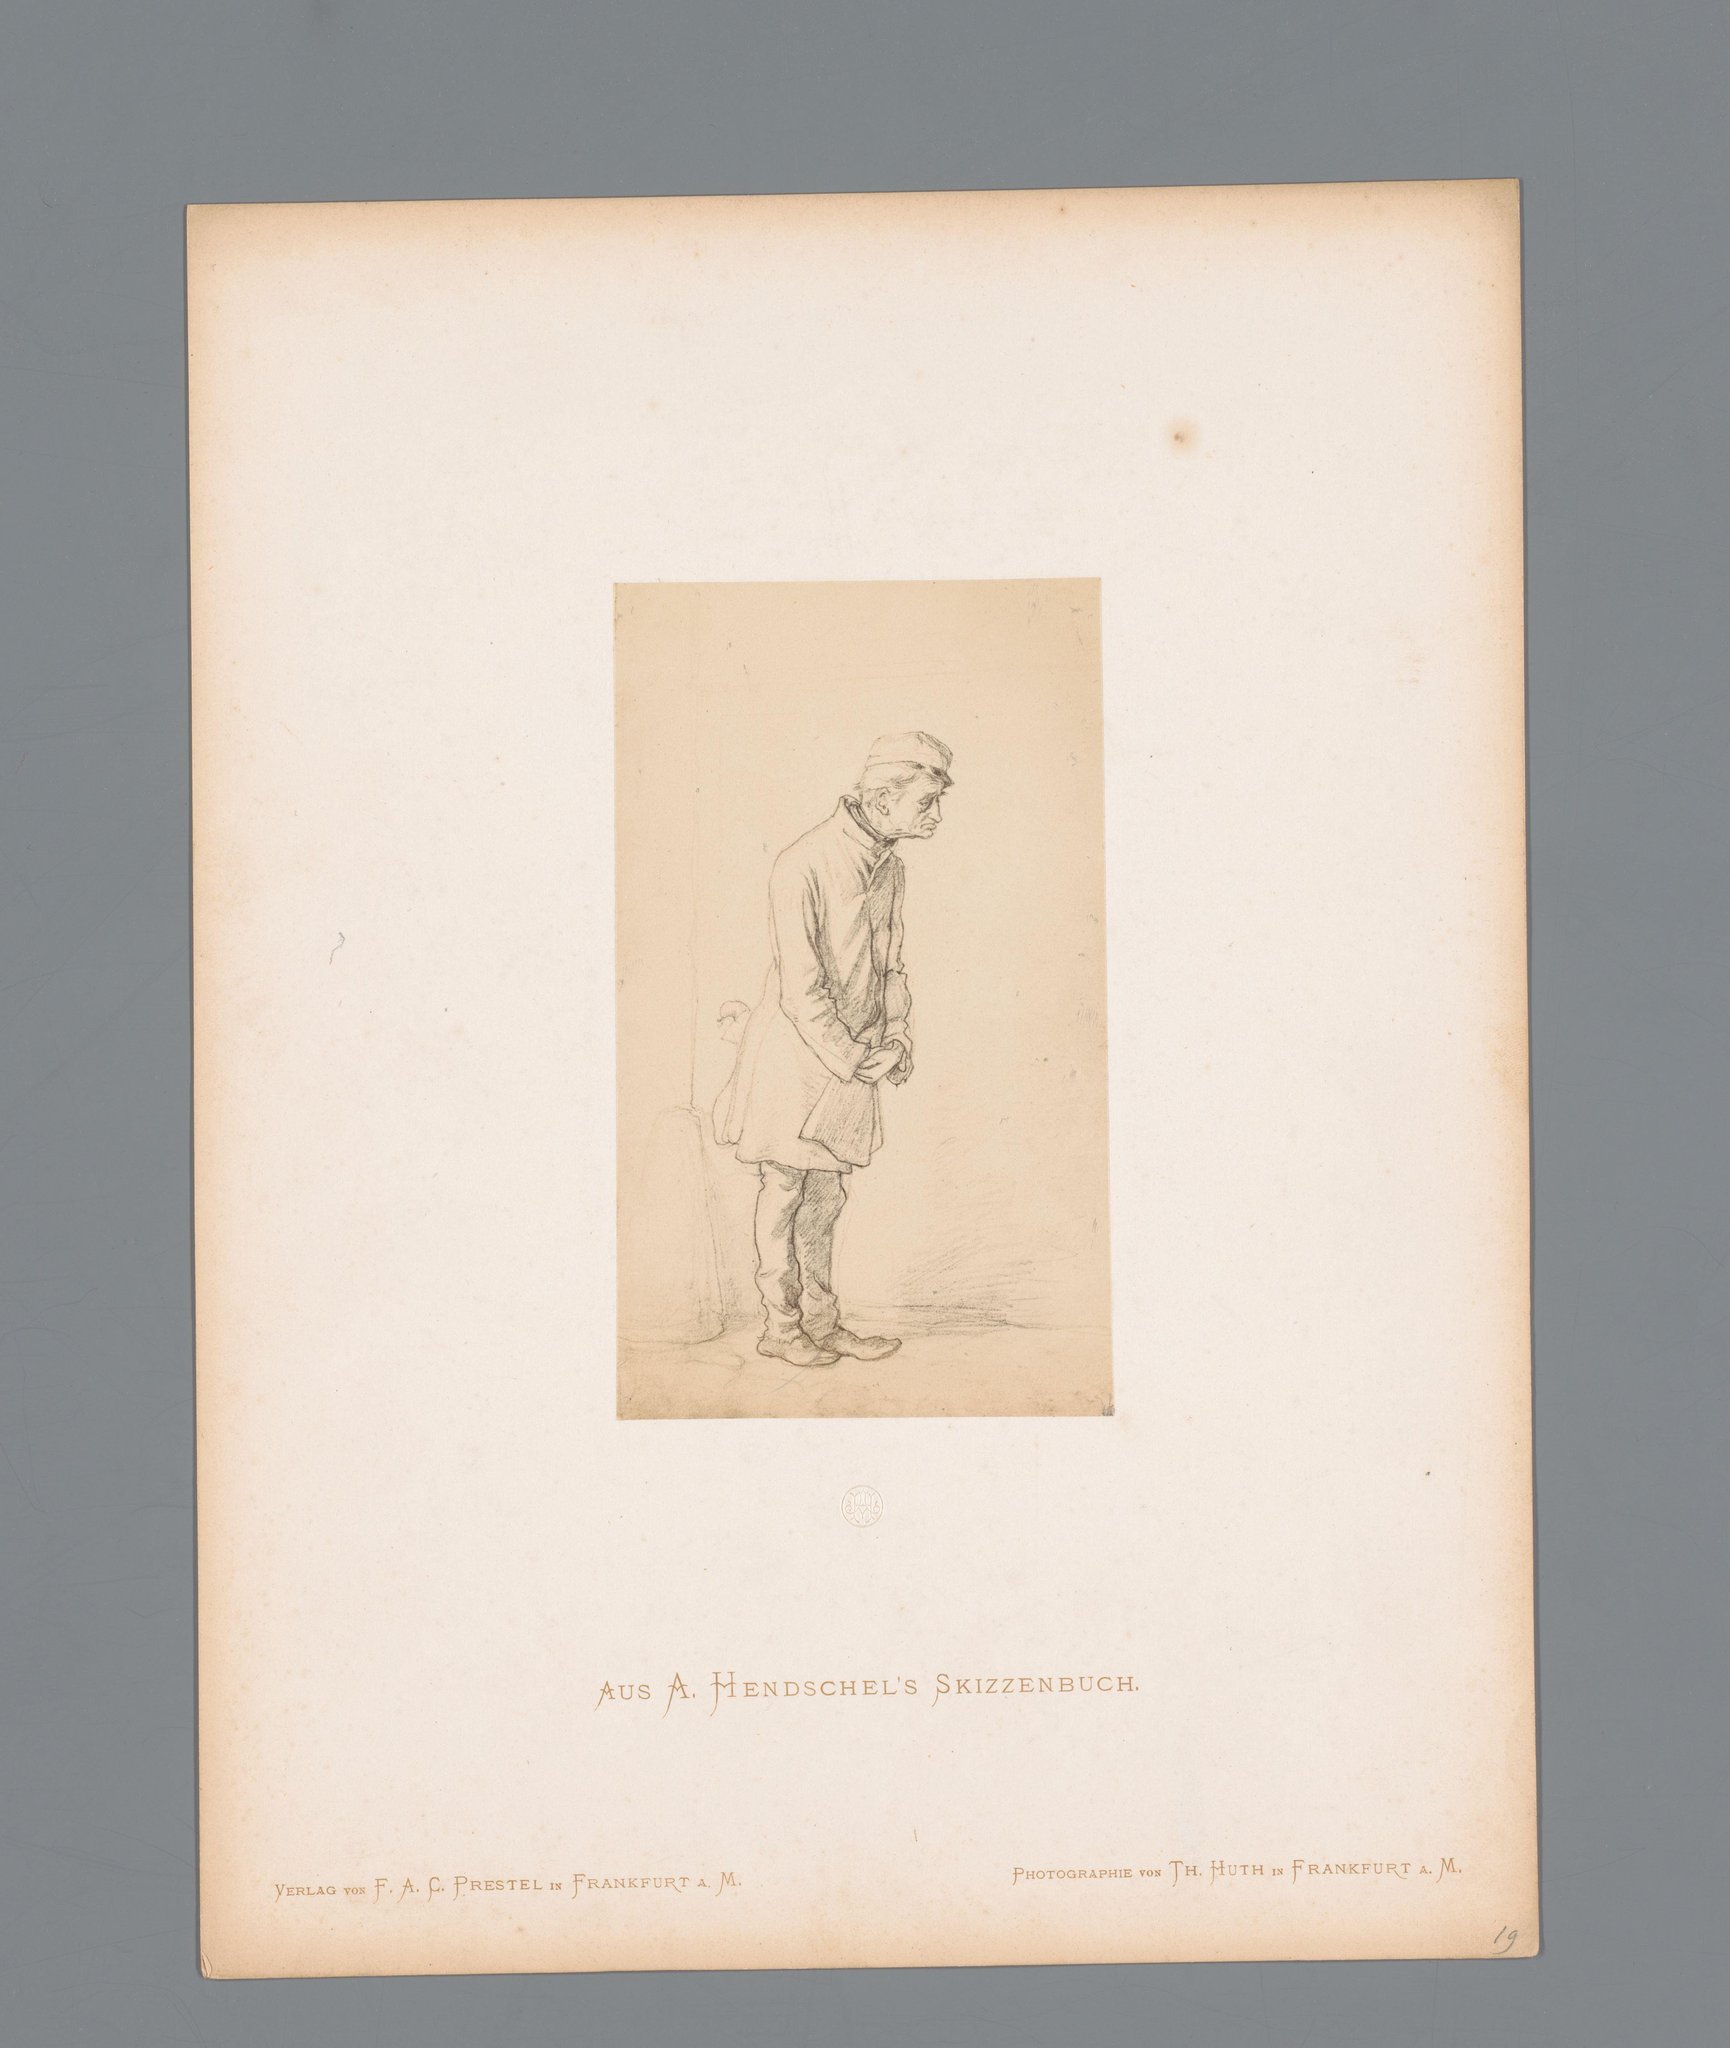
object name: reproduction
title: Fotoreproductie van een schets van een portret van een onbekende man, door Albert Hendschel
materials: photographic support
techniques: albumen print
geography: frankfurt am main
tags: historical persons not known by name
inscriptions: number: ‘19’, monogram: ‘AH’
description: Deze foto maakt deel uit van een omslag met 50 foto's op 48 bladen, een lijst van afbeeldingen en een titelblad.